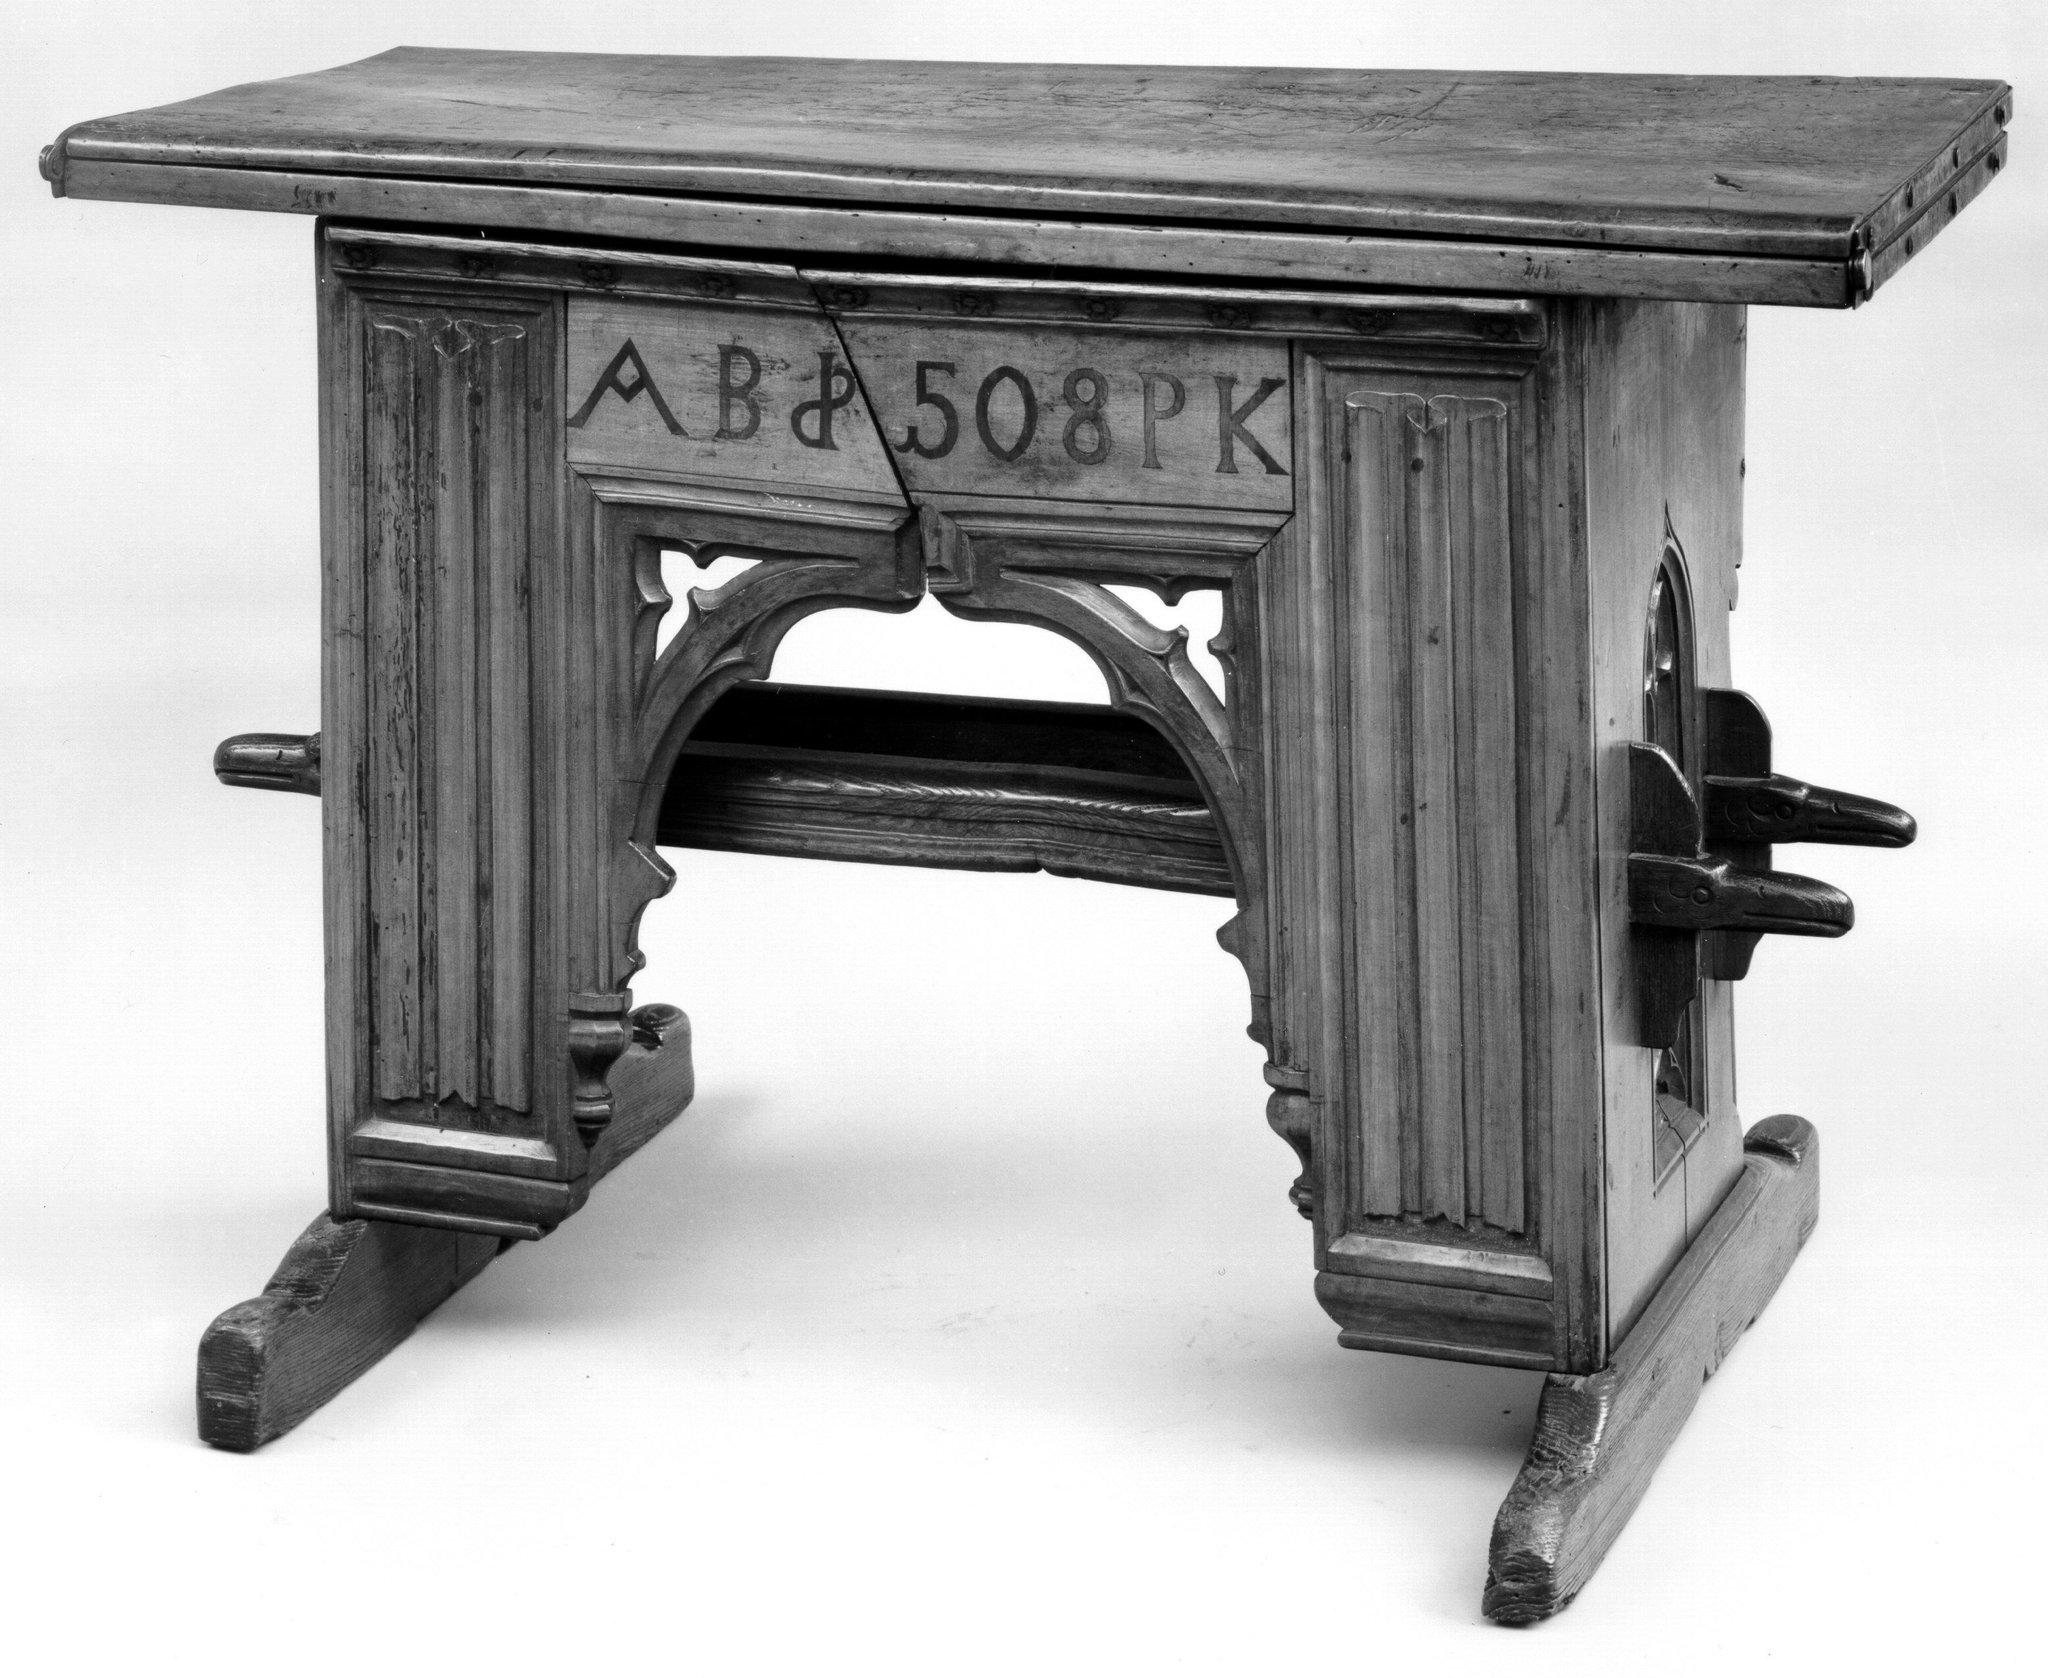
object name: folding table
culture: french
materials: wood